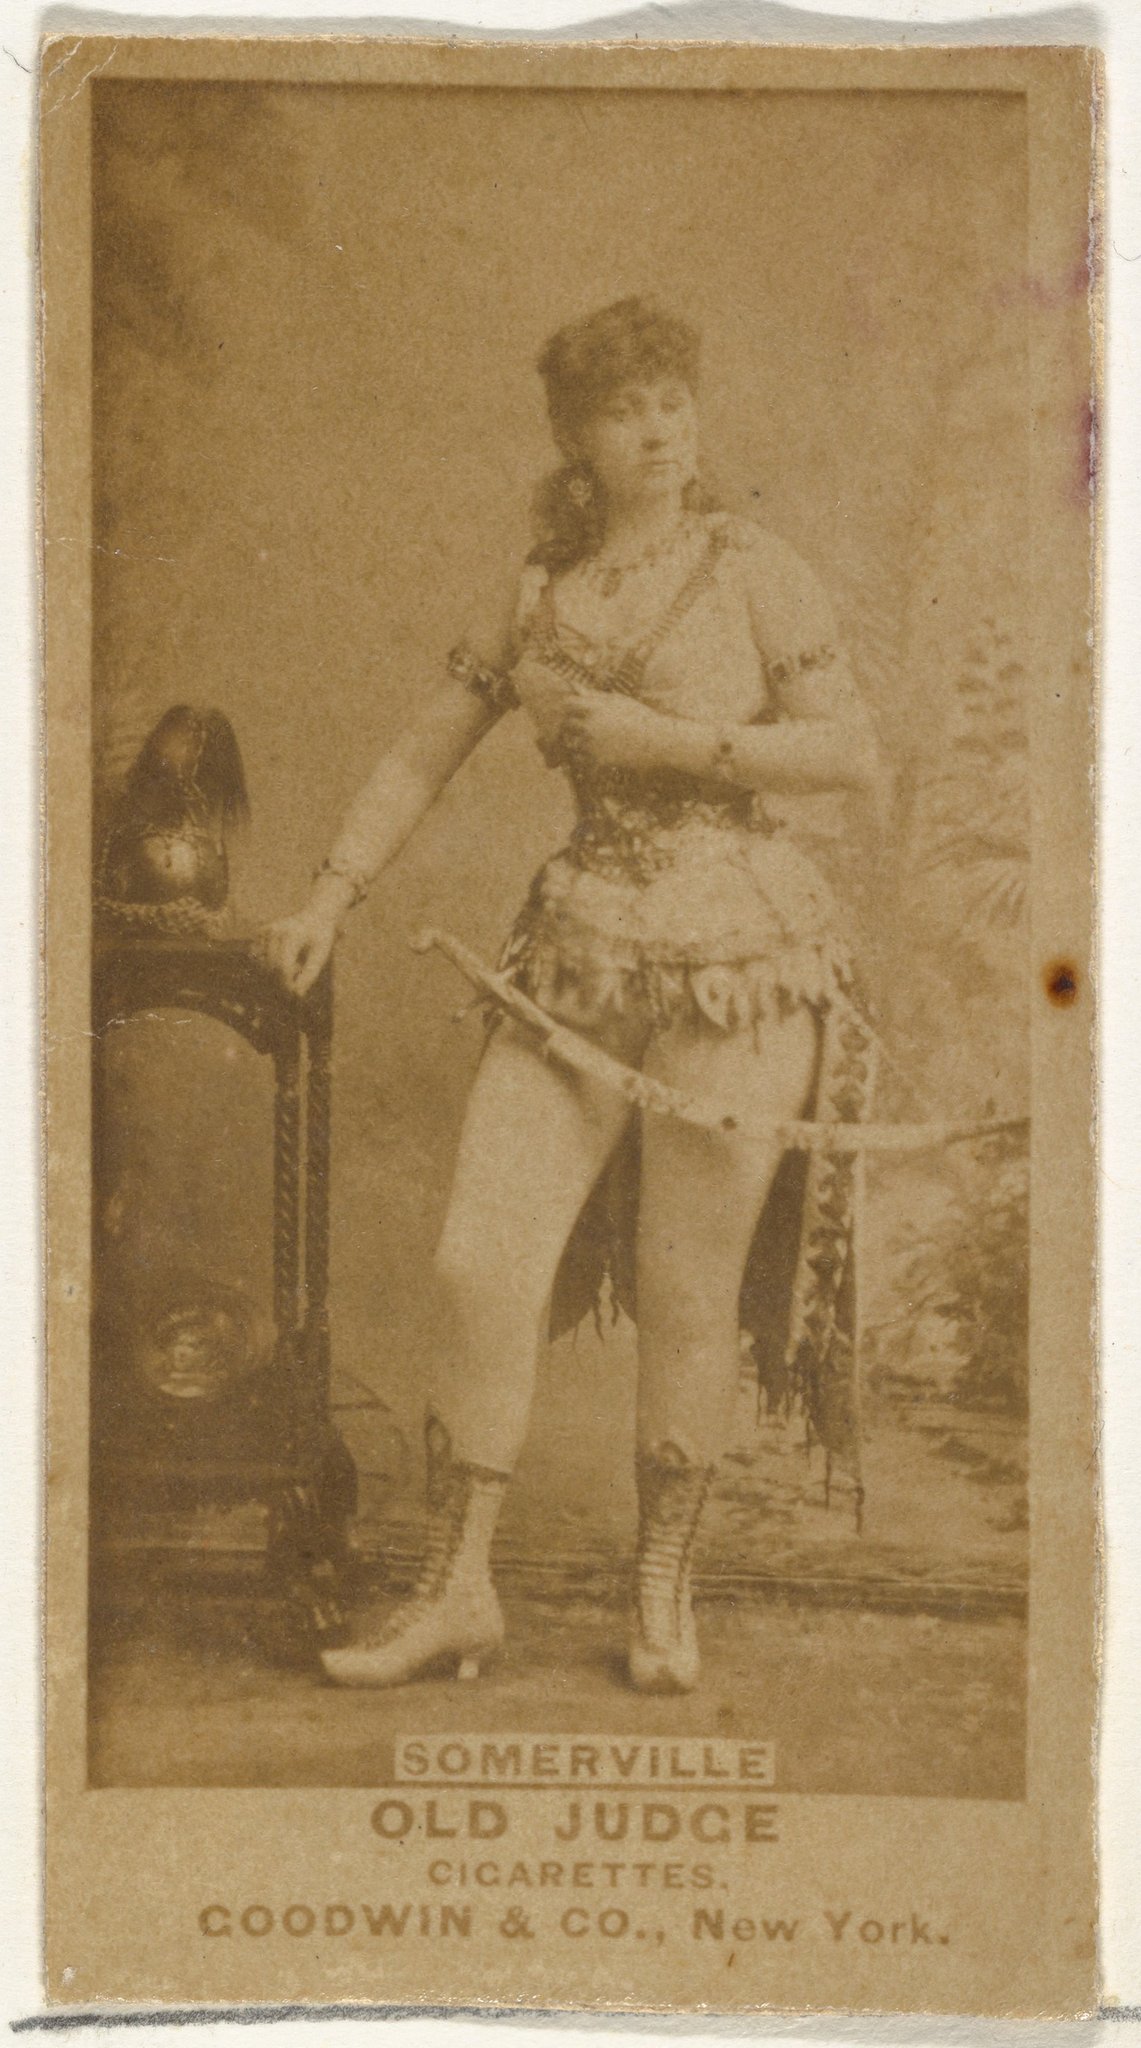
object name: photograph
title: Annie Somerville, from the Actors and Actresses series (N171) for Old Judge Cigarettes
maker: goodwin & company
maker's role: publisher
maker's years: 1850-1950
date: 1886-1890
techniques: albumen silver print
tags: portraits,women,actresses